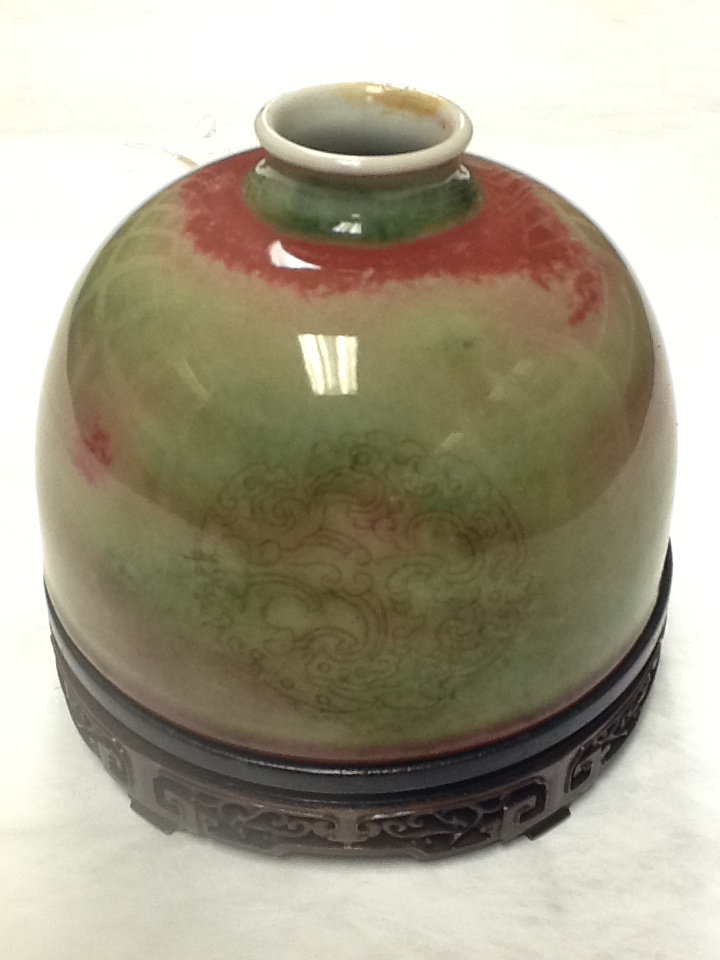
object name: water bottle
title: Writer's Water Bottle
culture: chinese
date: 1662-1722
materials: porcelain